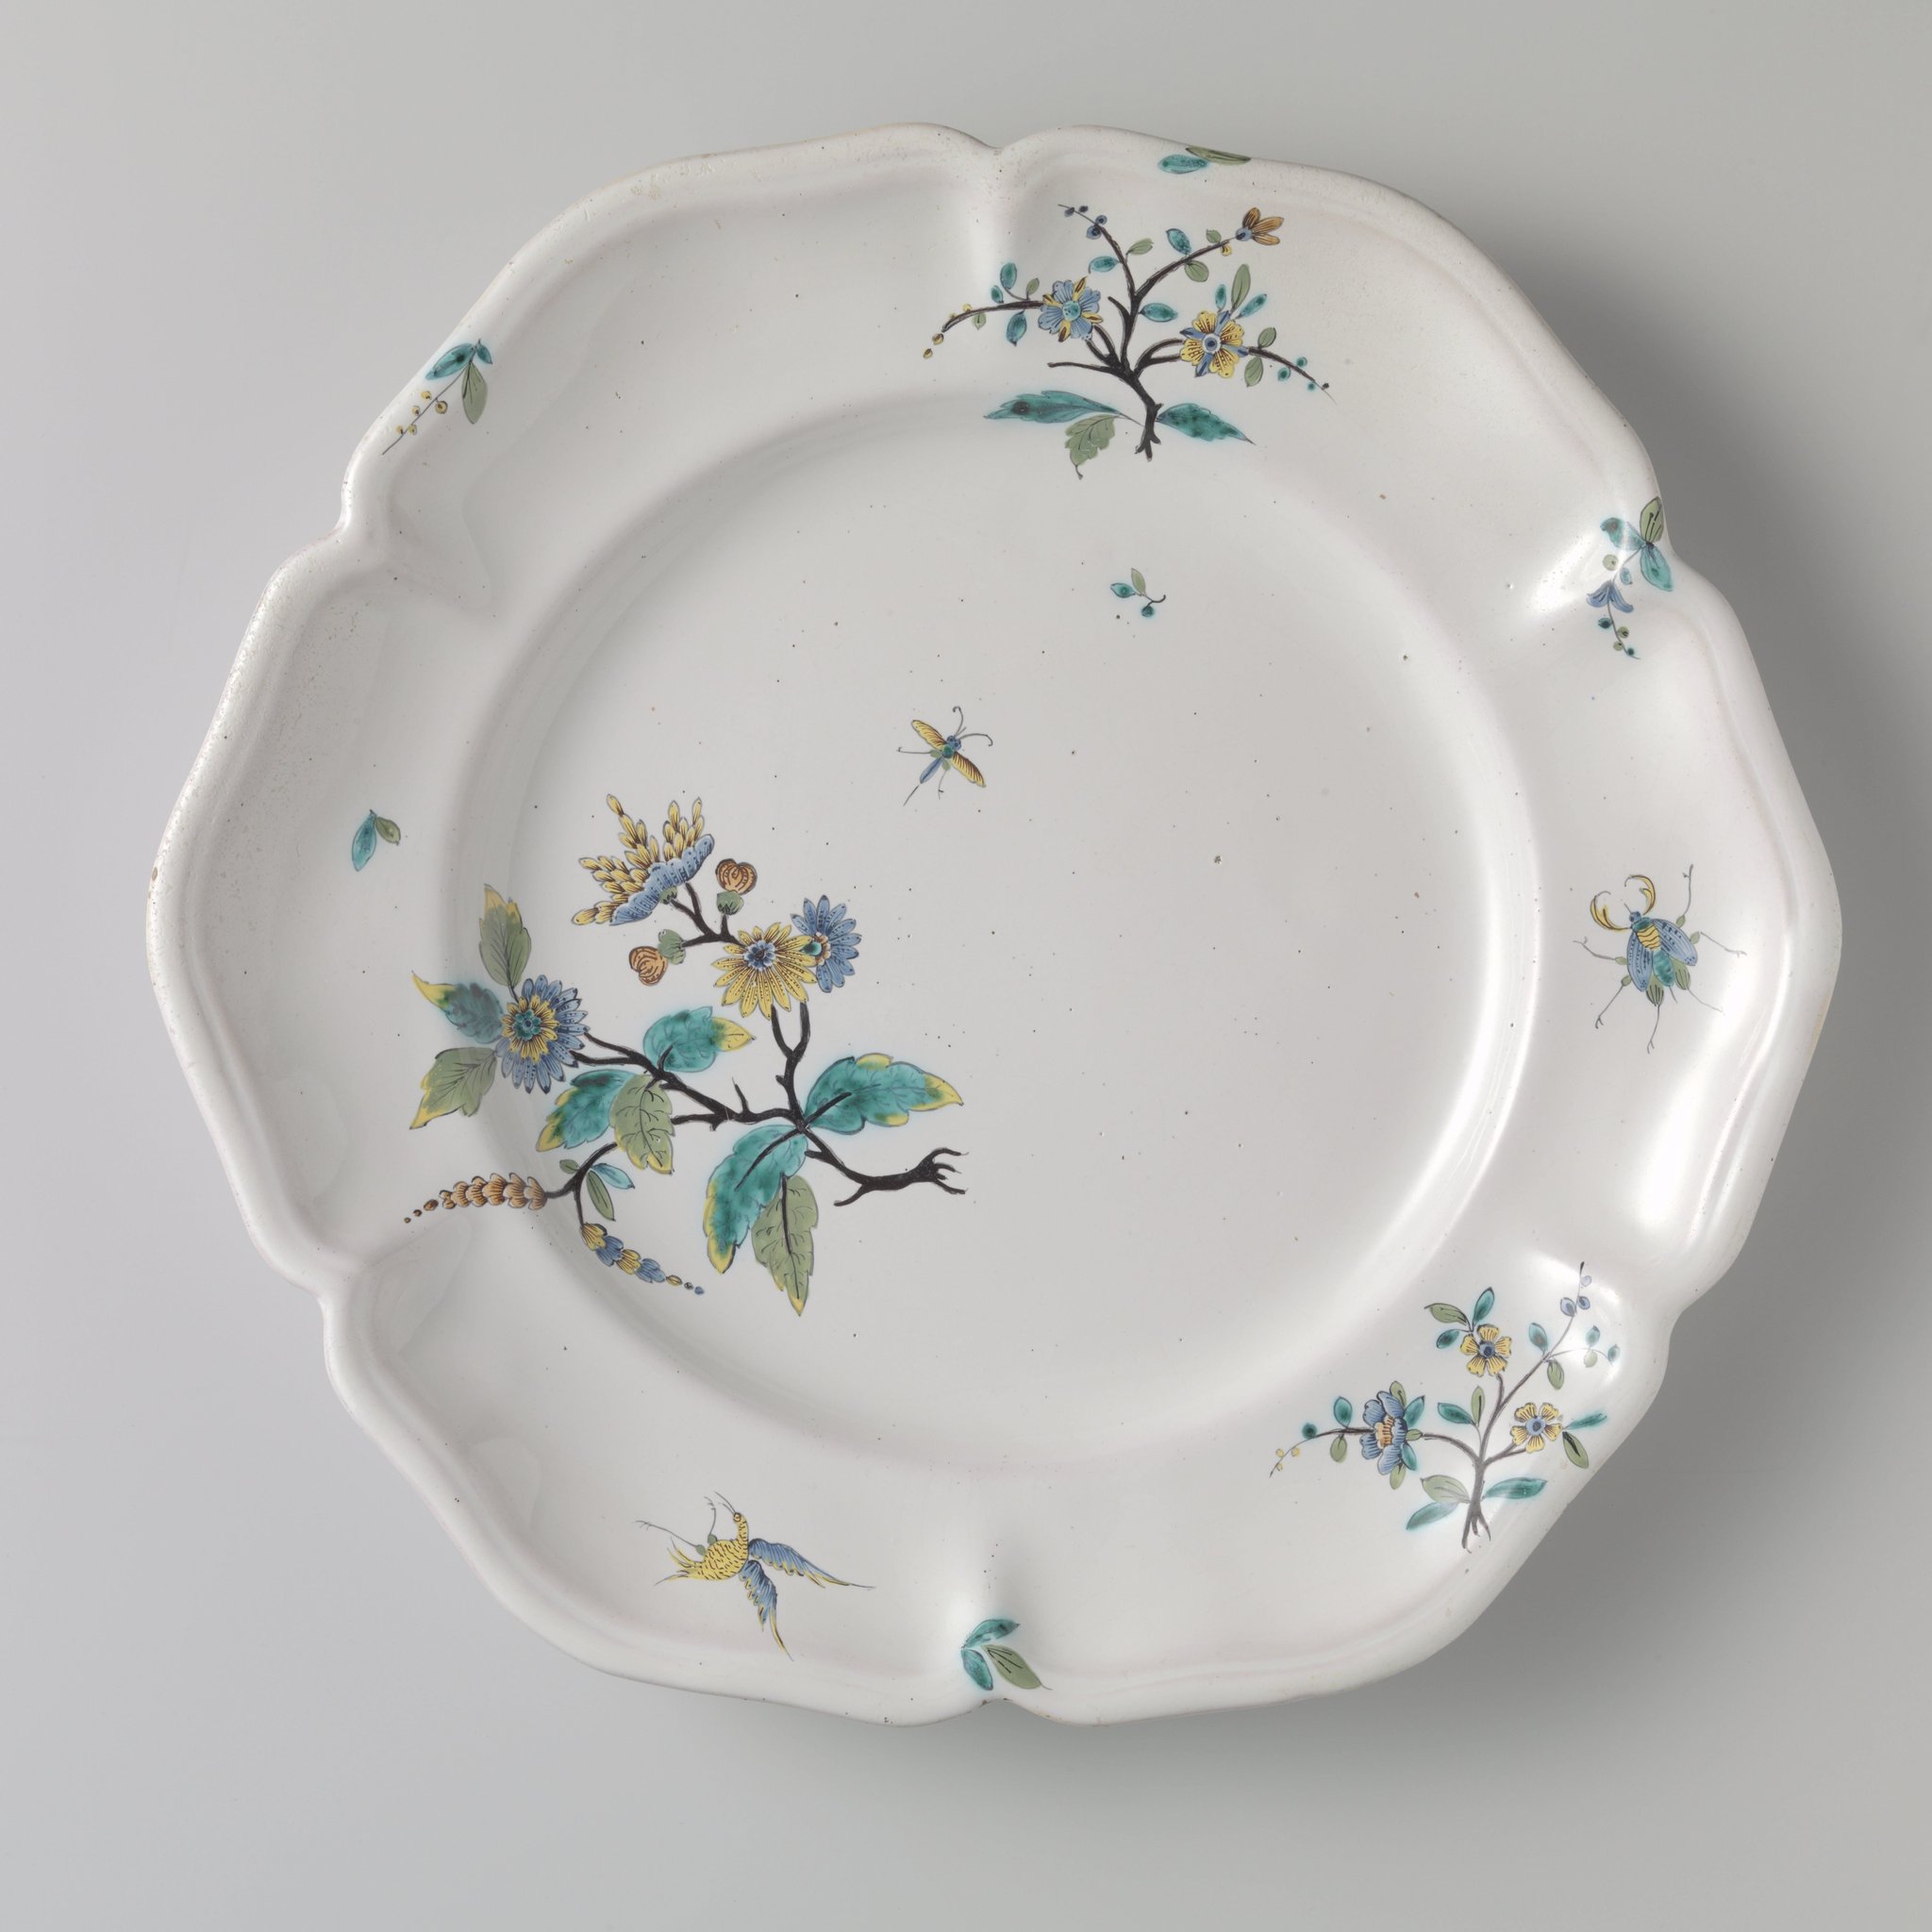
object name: platter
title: Schotel, veelkleurig beschilderd met bloemtakken, een vogel en insecten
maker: Anonymous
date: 1740-1750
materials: faience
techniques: kiln, painted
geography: straatsburg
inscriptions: mark: ‘R’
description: Dish. Faience with petit feu decoration in dark brown. Strasbourg (France), 1740 - 1750.